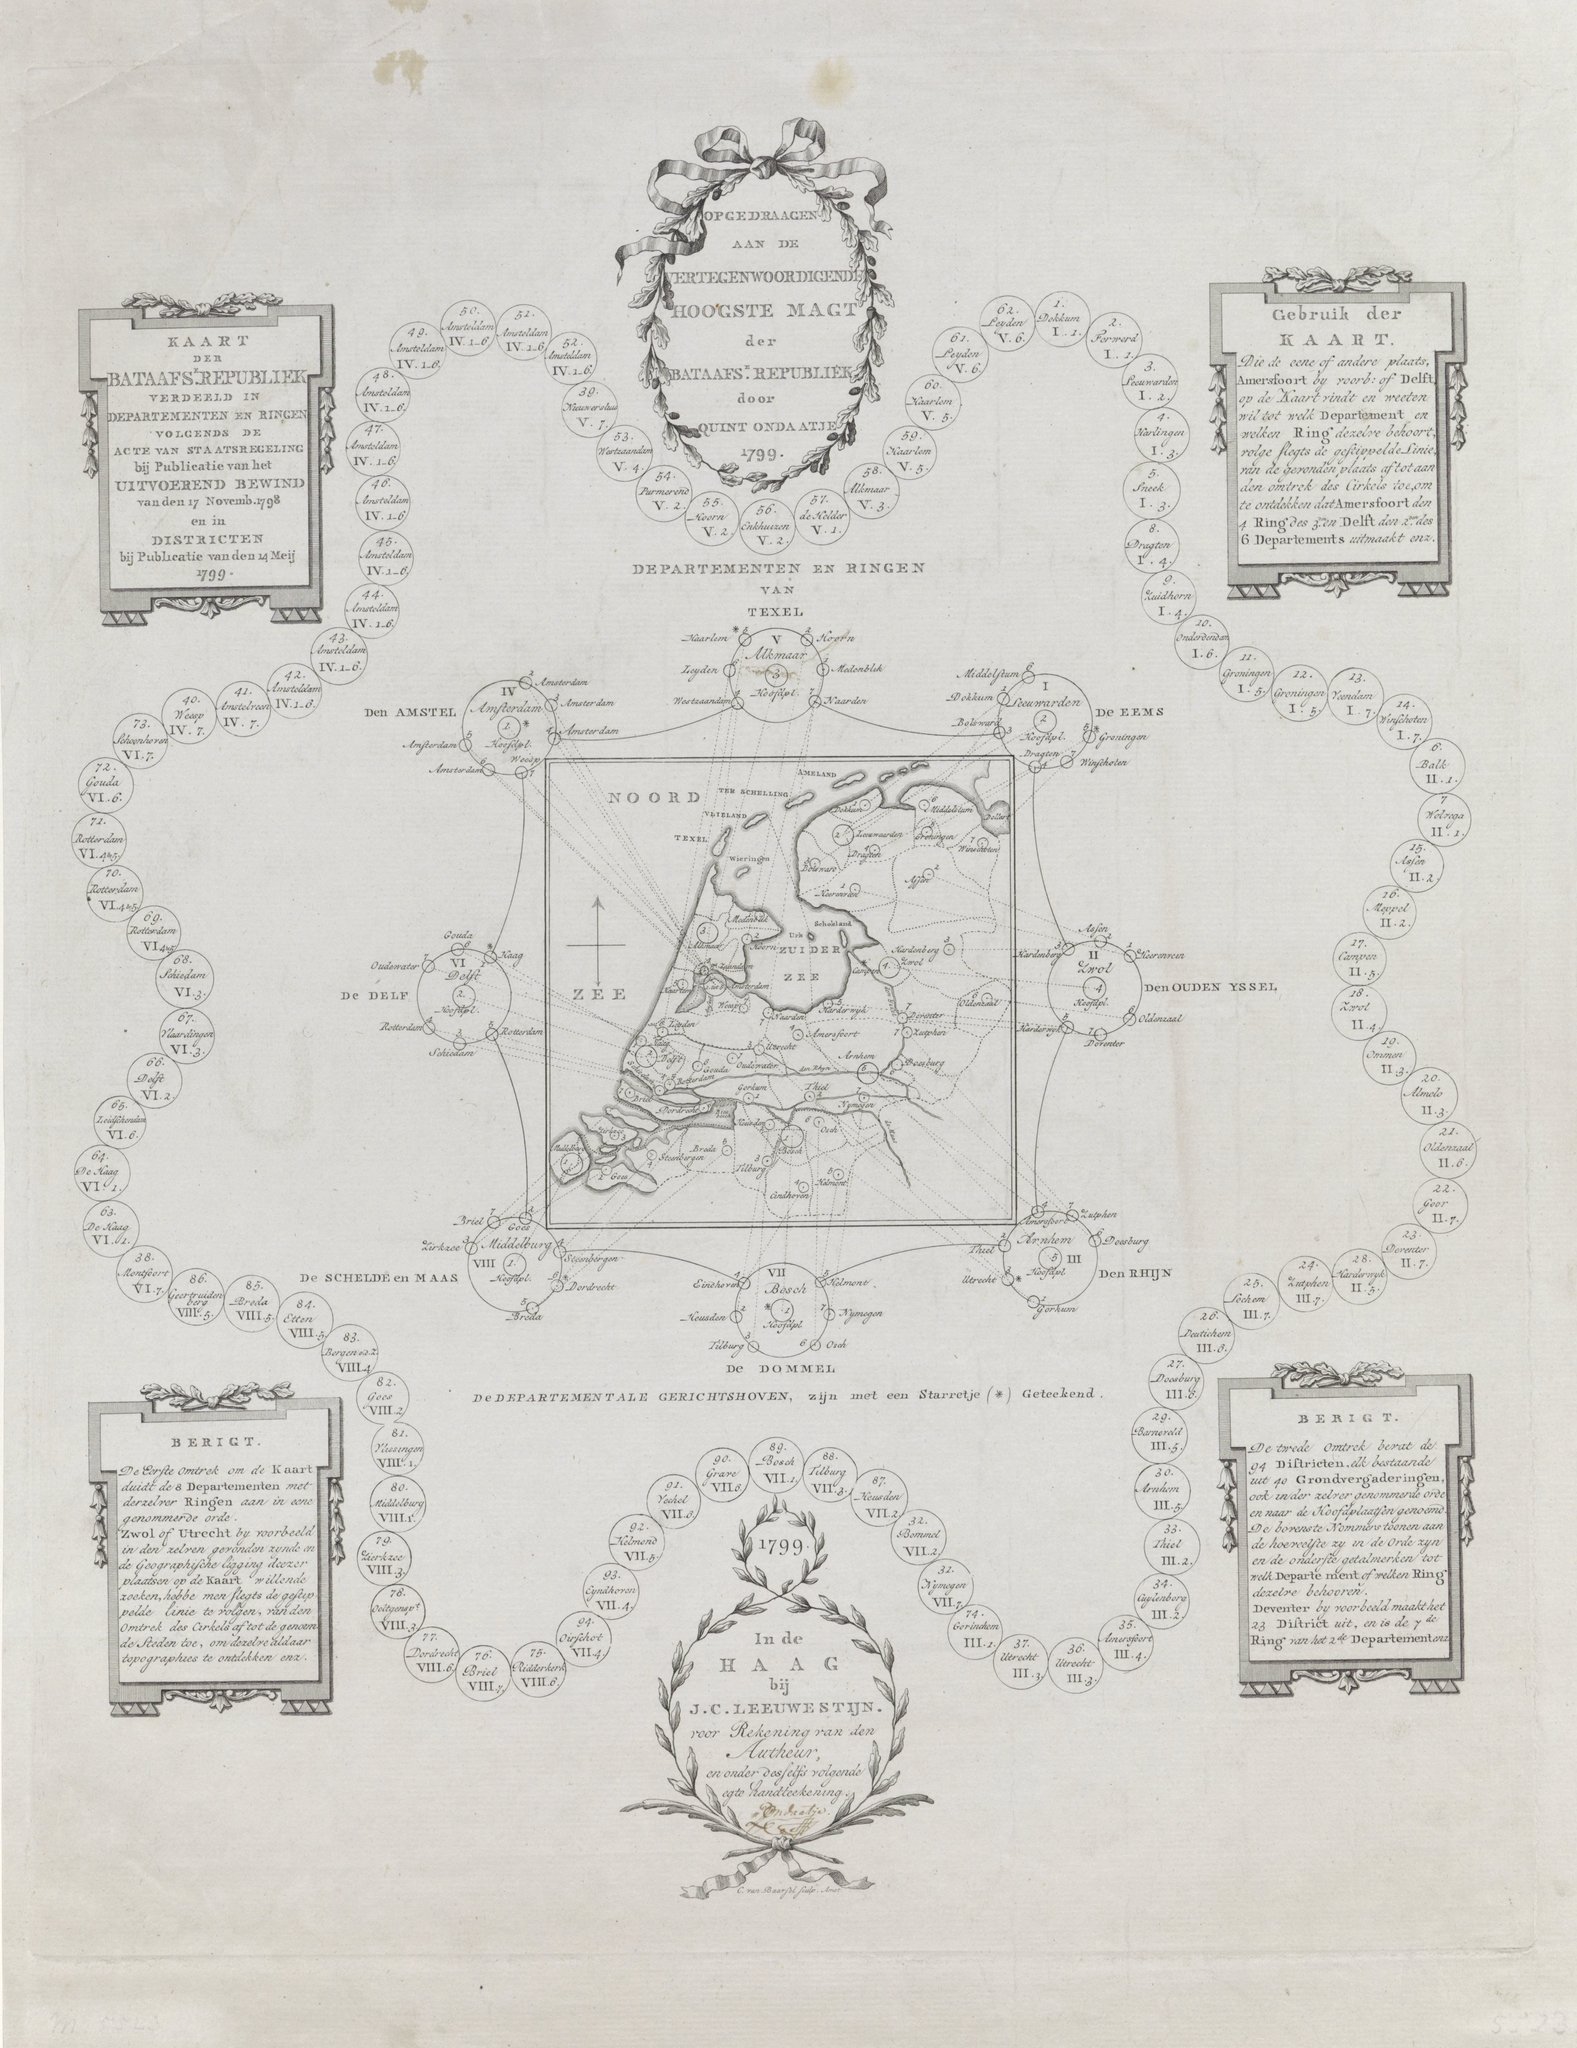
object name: print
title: Kaart van de Bataafse Republiek, 1799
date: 1799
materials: paper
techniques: engraving, etching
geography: netherlands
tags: maps of separate countries or regions, netherlands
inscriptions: collector's mark: Lugt 2228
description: Kaart van de indeling van de Bataafse Republiek in departementen ringen, volgens Acte van Staatsregeling bij publicatie van het Uitvoerend Bewind van 17 november 1798, en in districten volgens de publicatie van 14 mei 1799. Met cartouches met opdracht, gebruiksaanwijzing en twee berichten. Onderaan bij het adres gesigneerd door Ondaatje.